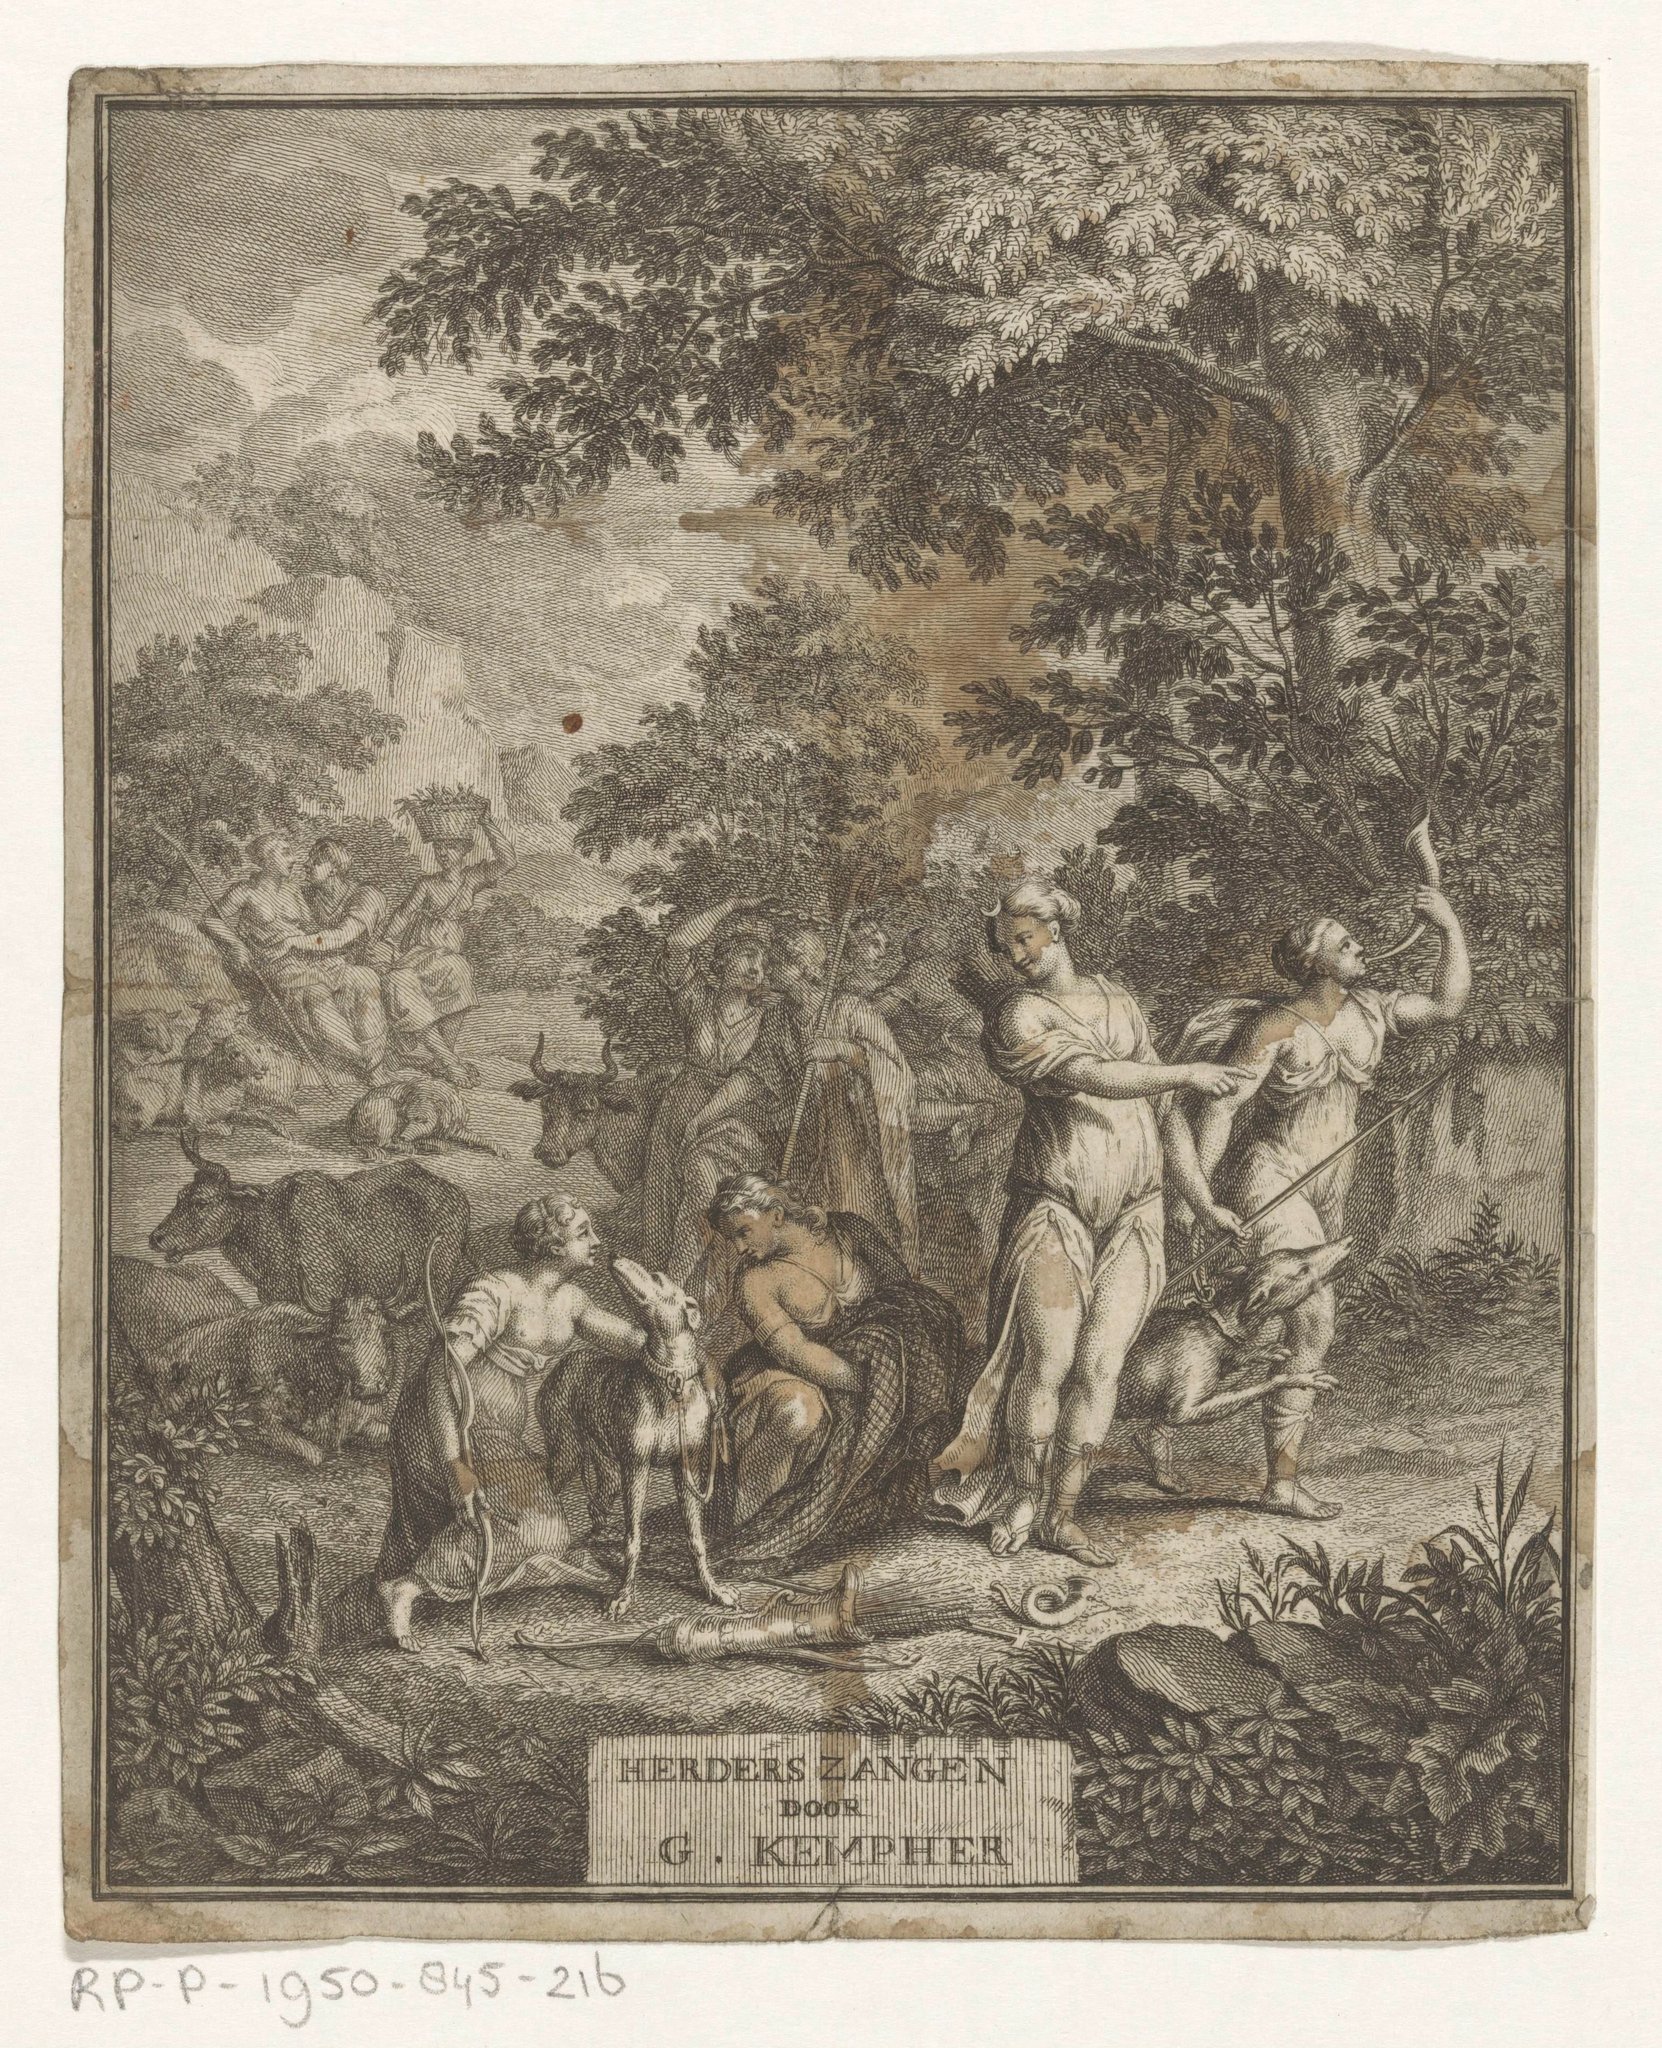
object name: print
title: Diana en herders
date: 1732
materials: paper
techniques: engraving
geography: leiden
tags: (story of) diana (artemis), herding, herdsman, herdswoman, shepherd, shepherdess, cowherd, etc.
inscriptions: collector's mark: Lugt 2228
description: Titelpagina voor: Kempher, Gerard. Herderszangen. Leiden: Langerak, Johan Arnold, 1732. Prent afkomstig uit een plakalbum met titelprenten, ornamenten etc. op blauw papier in 1983 uit elkaar gehaald. Volgens een notitie op verso zat de prent op p. 216 van dit album.